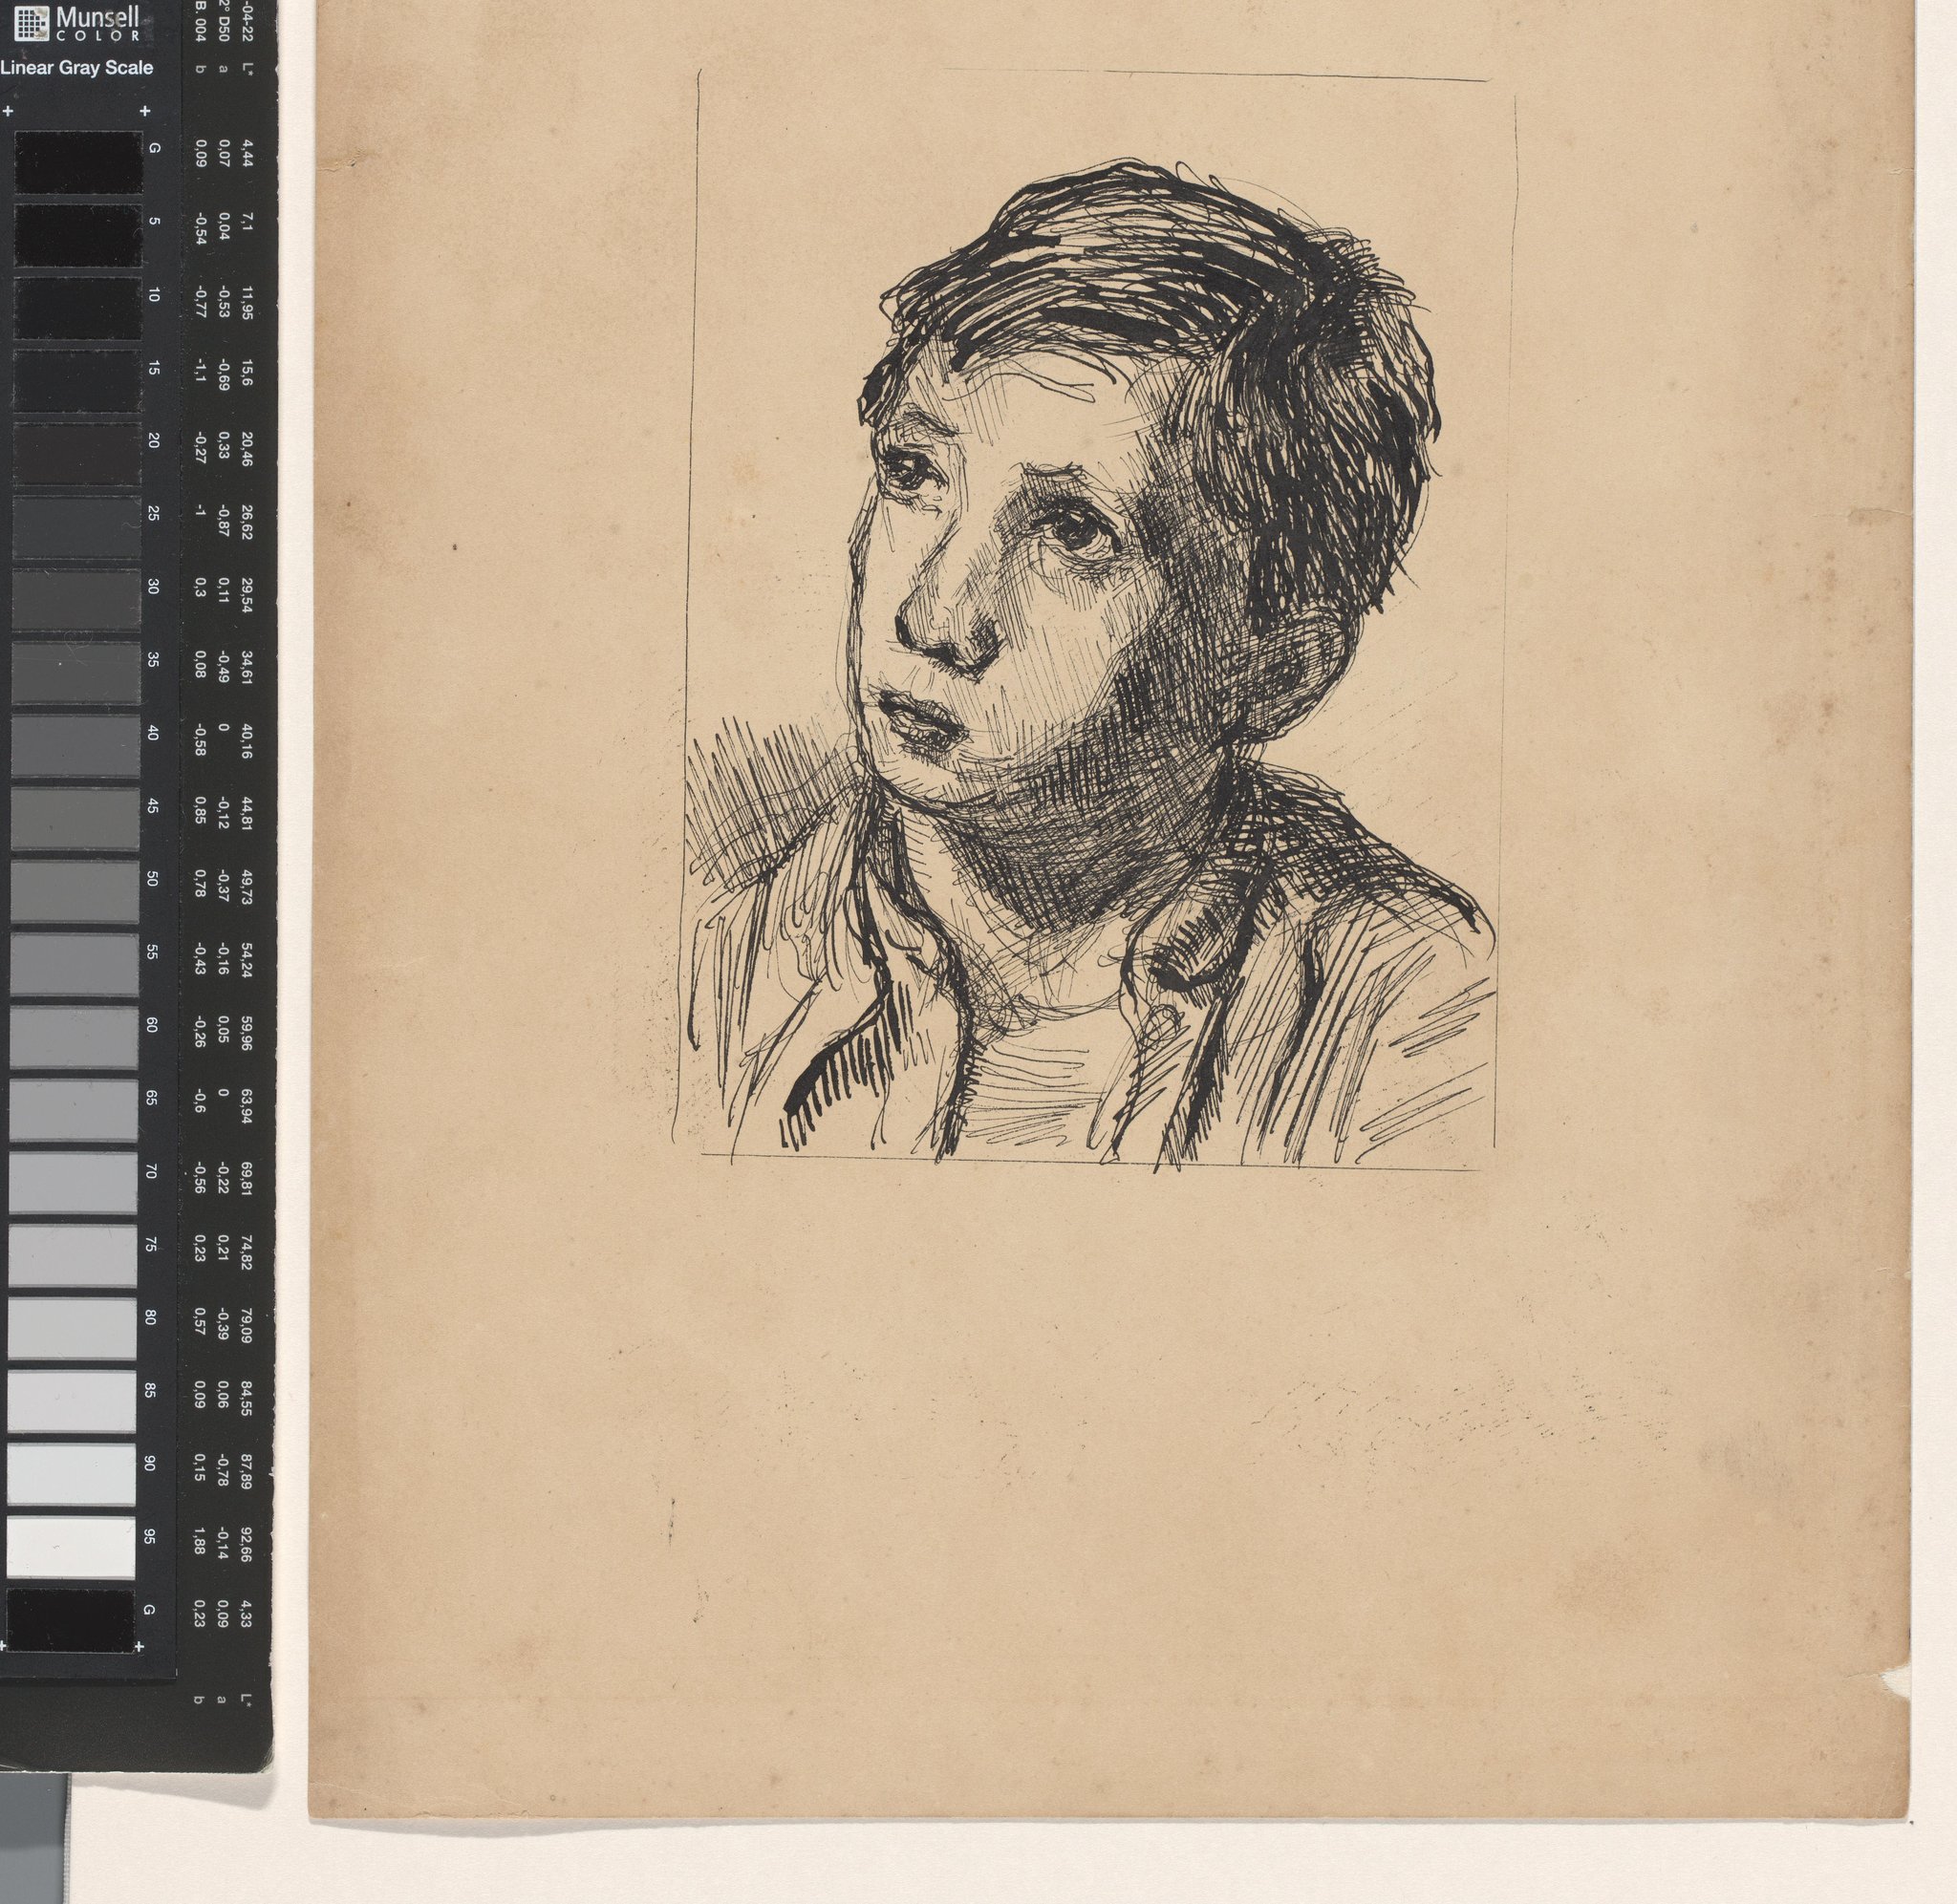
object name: schetsblad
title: Jongenshoofd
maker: johanna behrend-croiset van der kop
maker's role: draughtsman, painter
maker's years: 1861-1943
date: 1880-1900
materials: ink, paper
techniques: pen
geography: netherlands